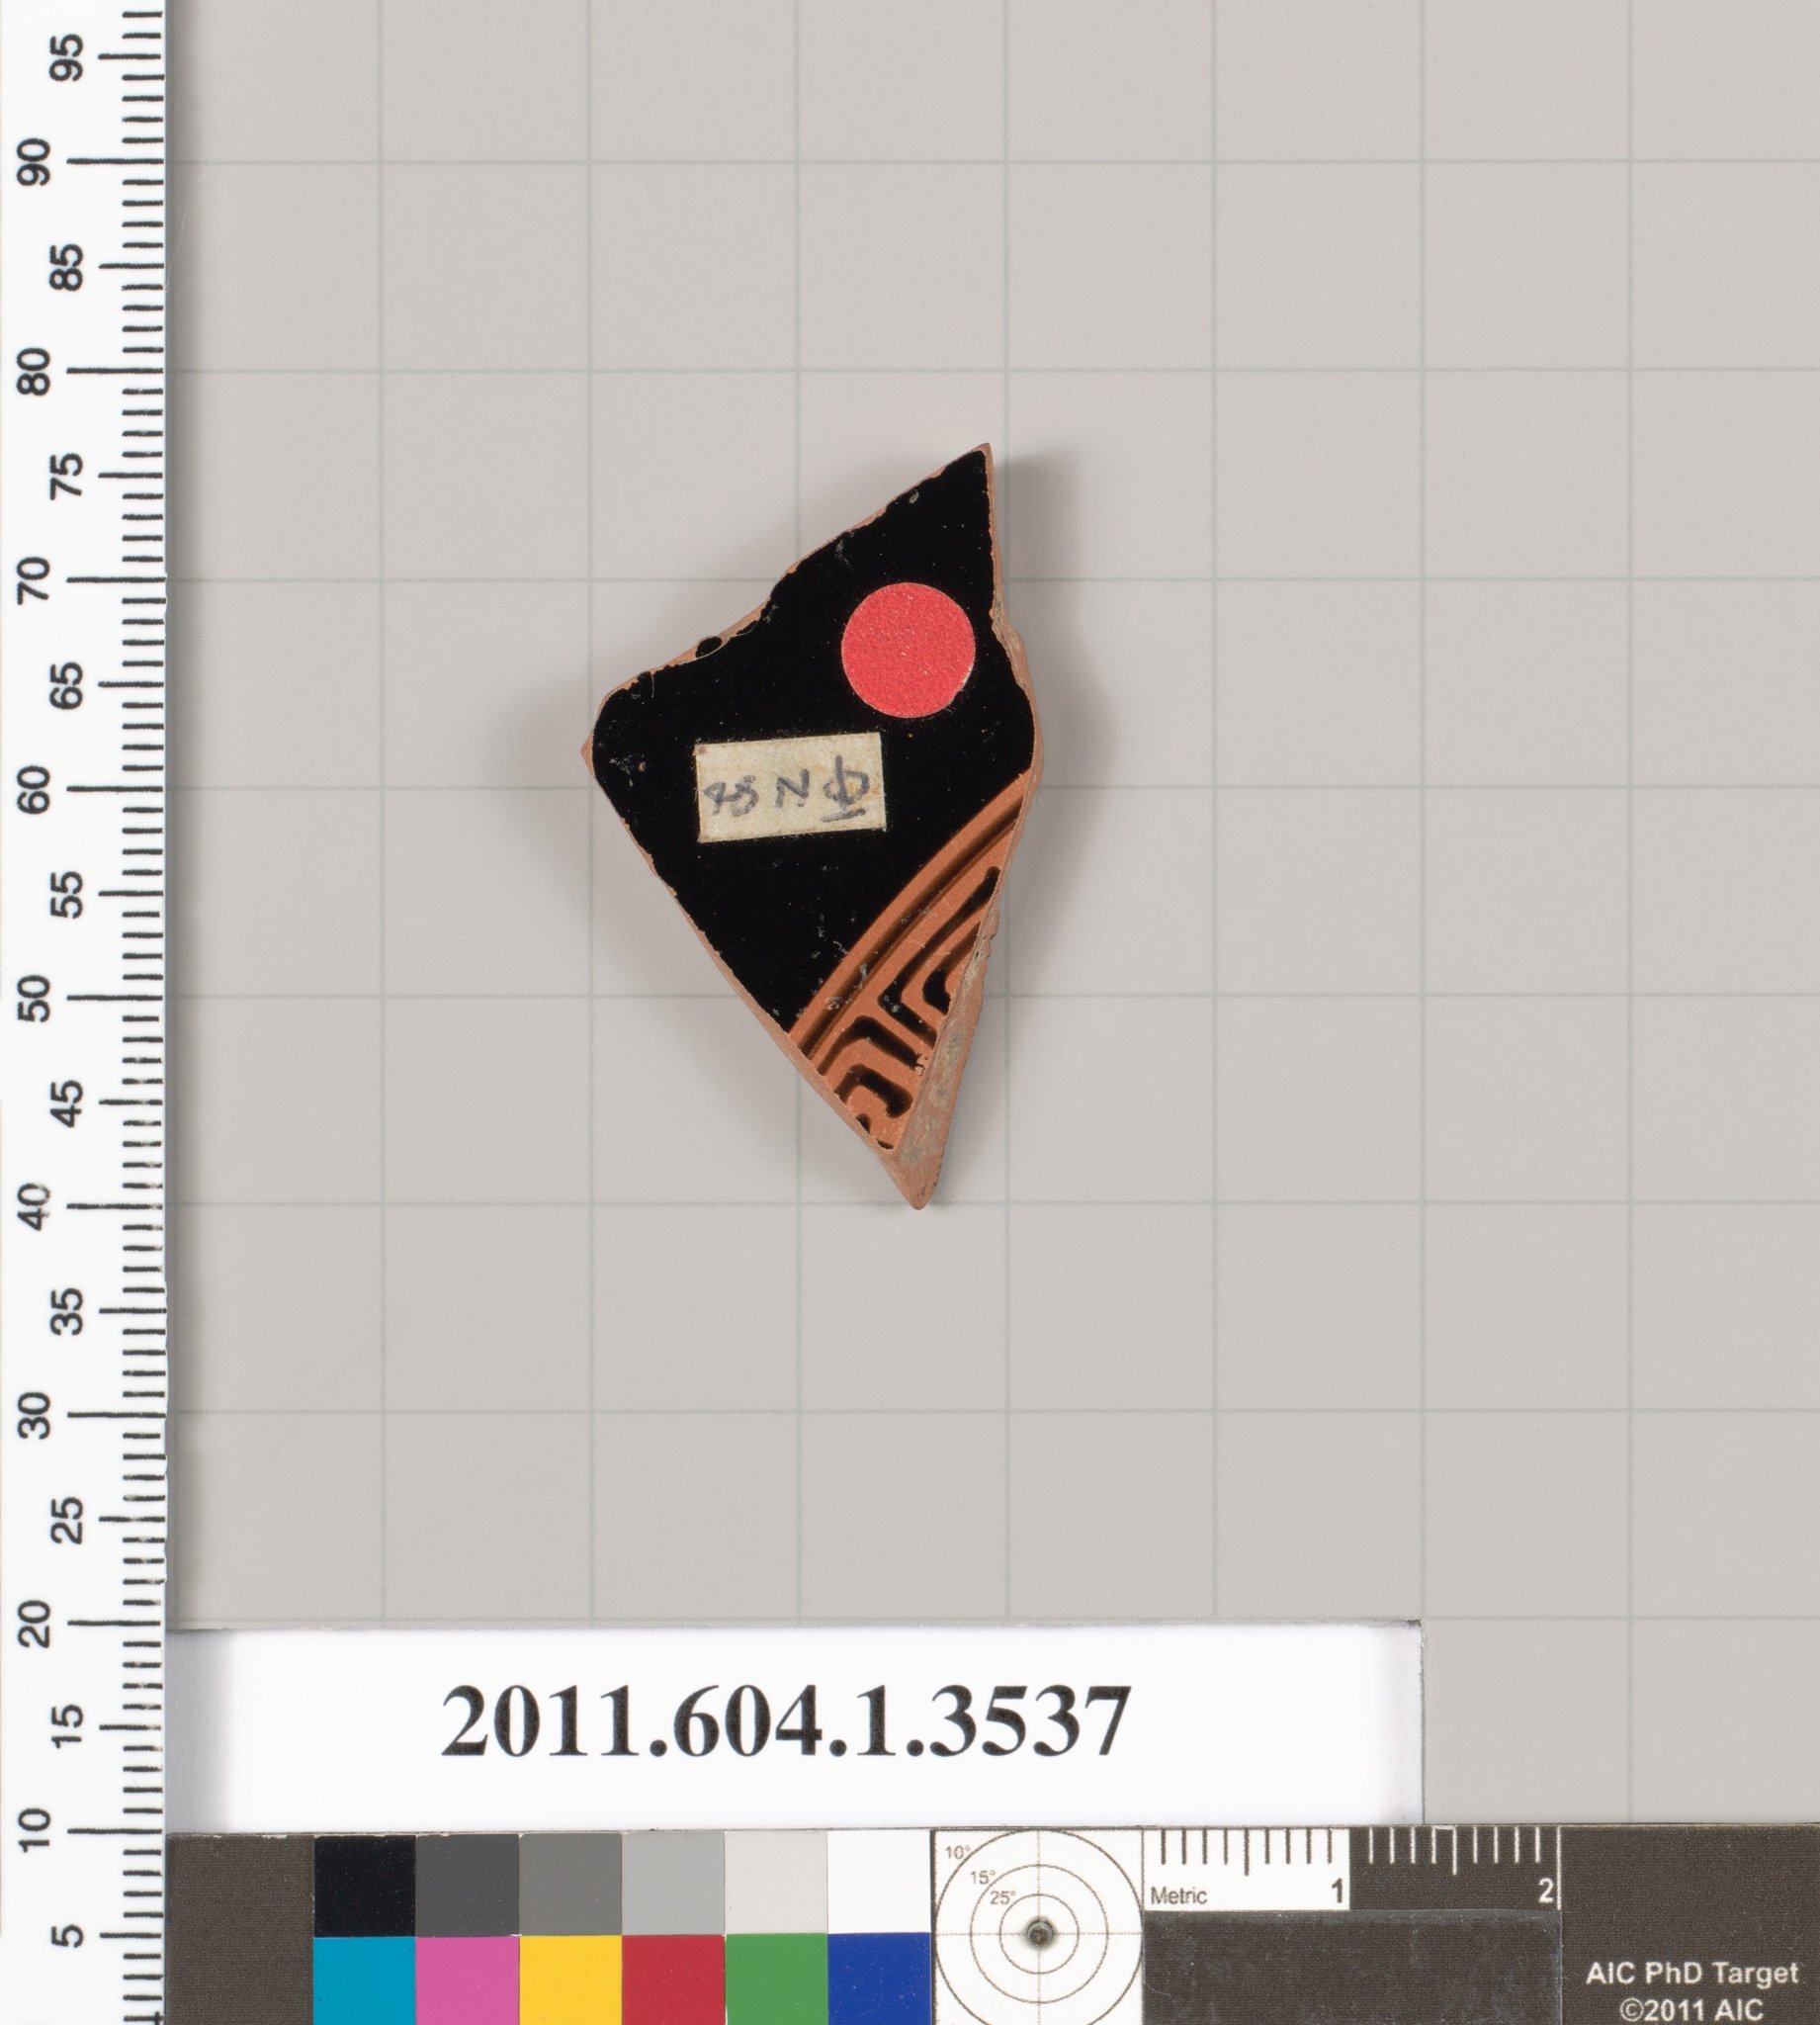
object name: kylix fragment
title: Terracotta fragment of a kylix (drinking cup)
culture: greek, attic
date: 510-490 BCE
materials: terracotta